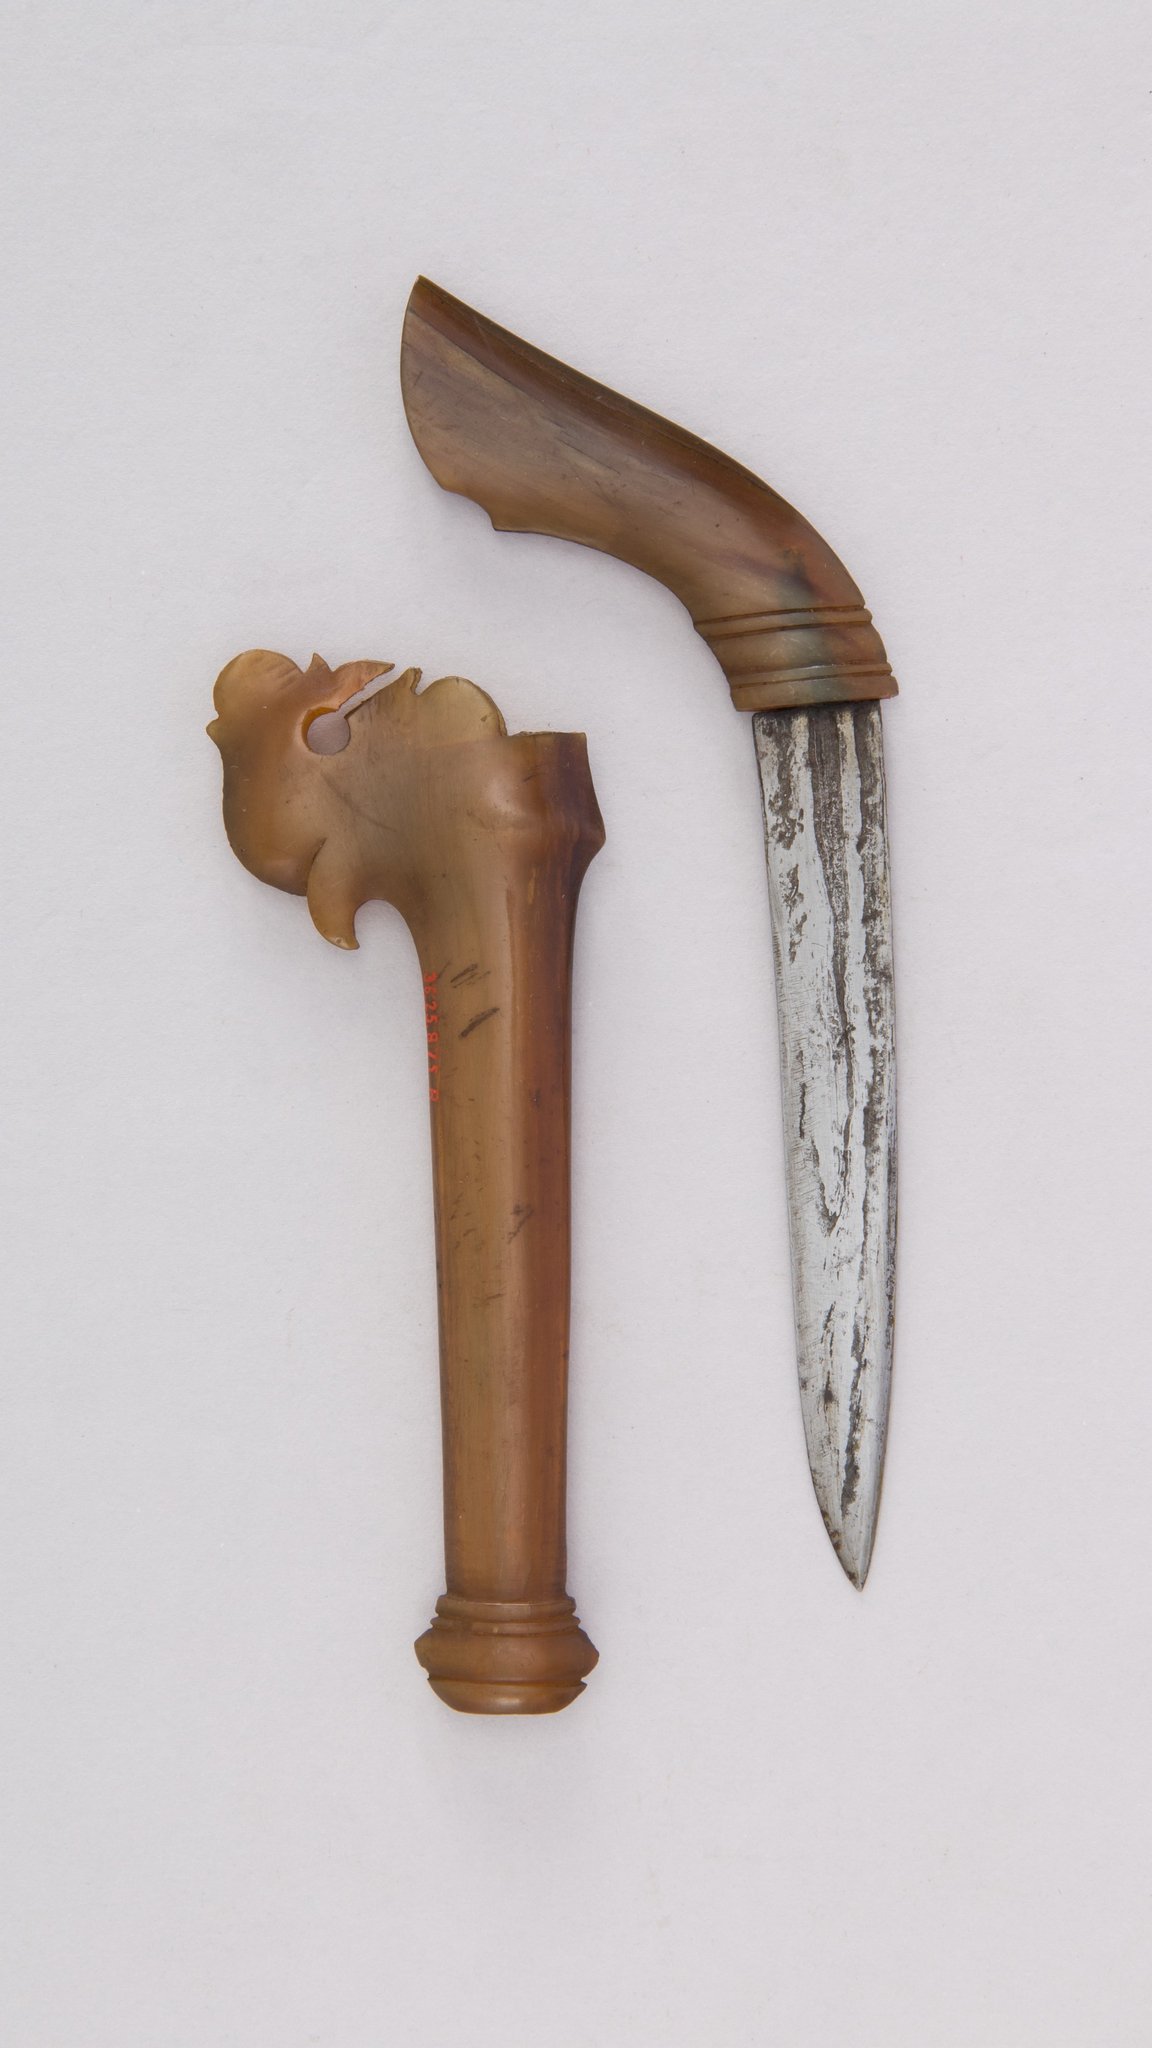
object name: knife with sheath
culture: indonesian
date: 1701-1900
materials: horn, steel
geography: sulawesi